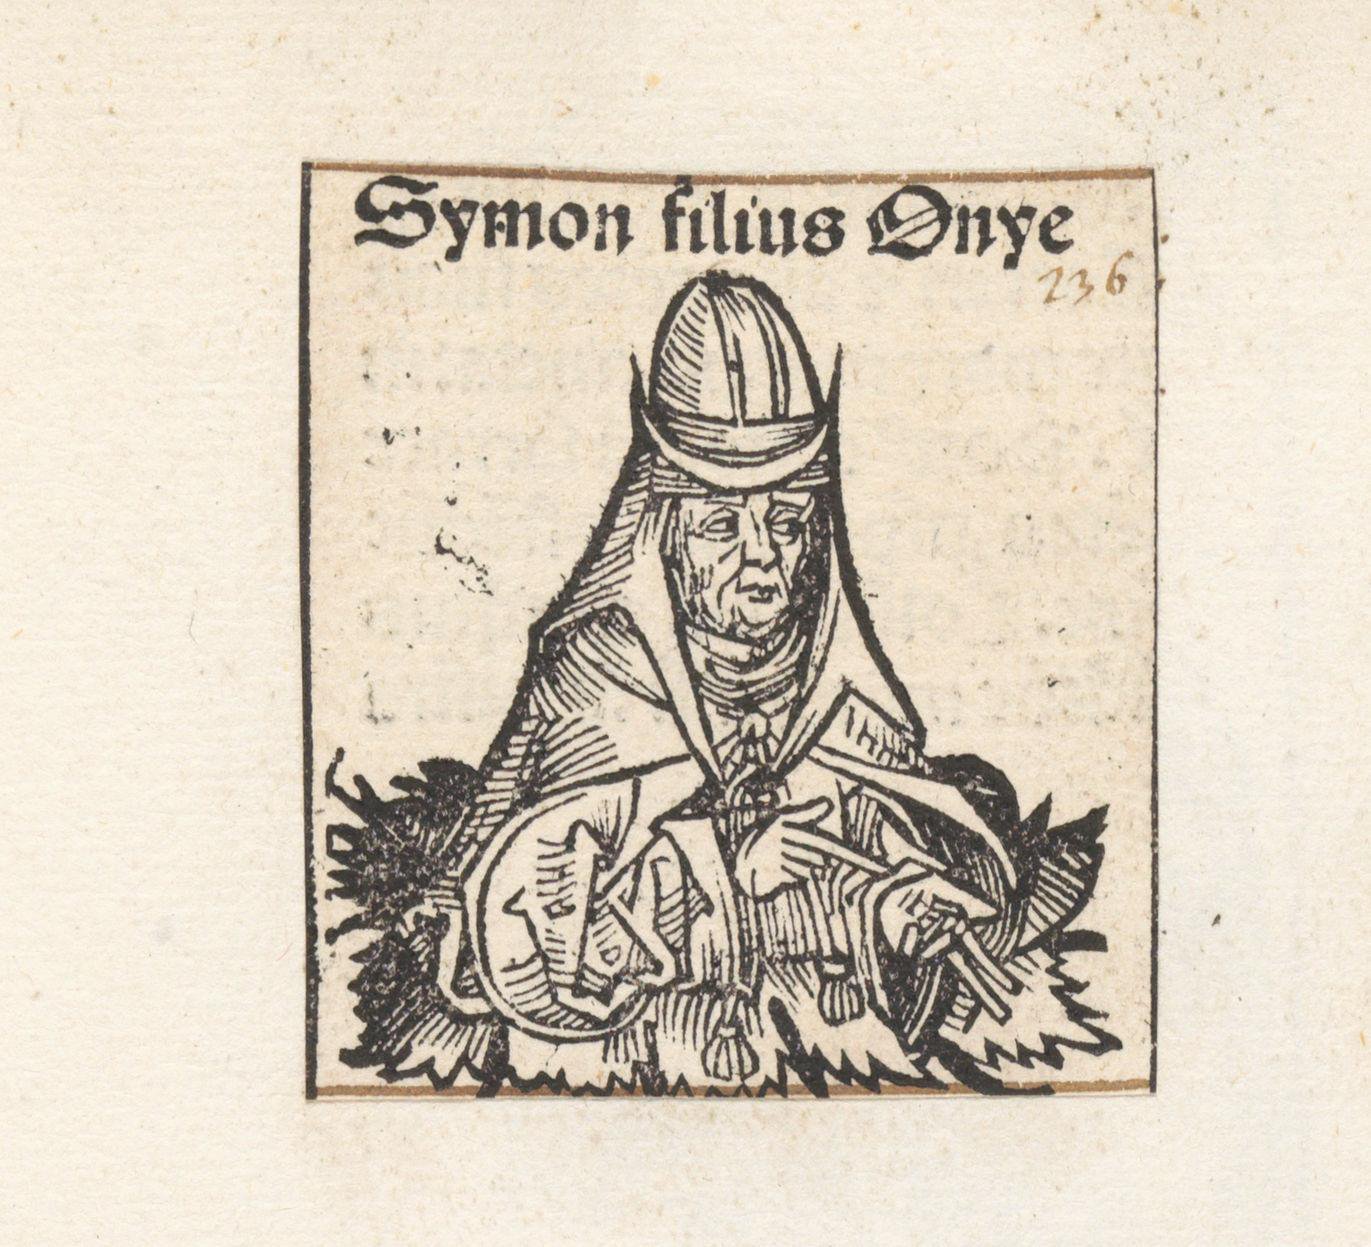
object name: album leaf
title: Simon I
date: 1493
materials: paper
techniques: letterpress printing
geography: nuremberg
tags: high priest ~ hierarchy of priests, persons from the old testament (not in biblical context, nor occurring in legendary/historical extensions included in division 71)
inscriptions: inscription: ‘236’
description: Een bloemkelk met een man in priesterkledij, naar rechts gekeerd. De tekst identificeert hem als Simon, hogepriester en zoon van Onias I. De voorstelling is onderdeel van de opeenvolging priesters in de Liber Chronicarum. De prent maakt deel uit van een album.